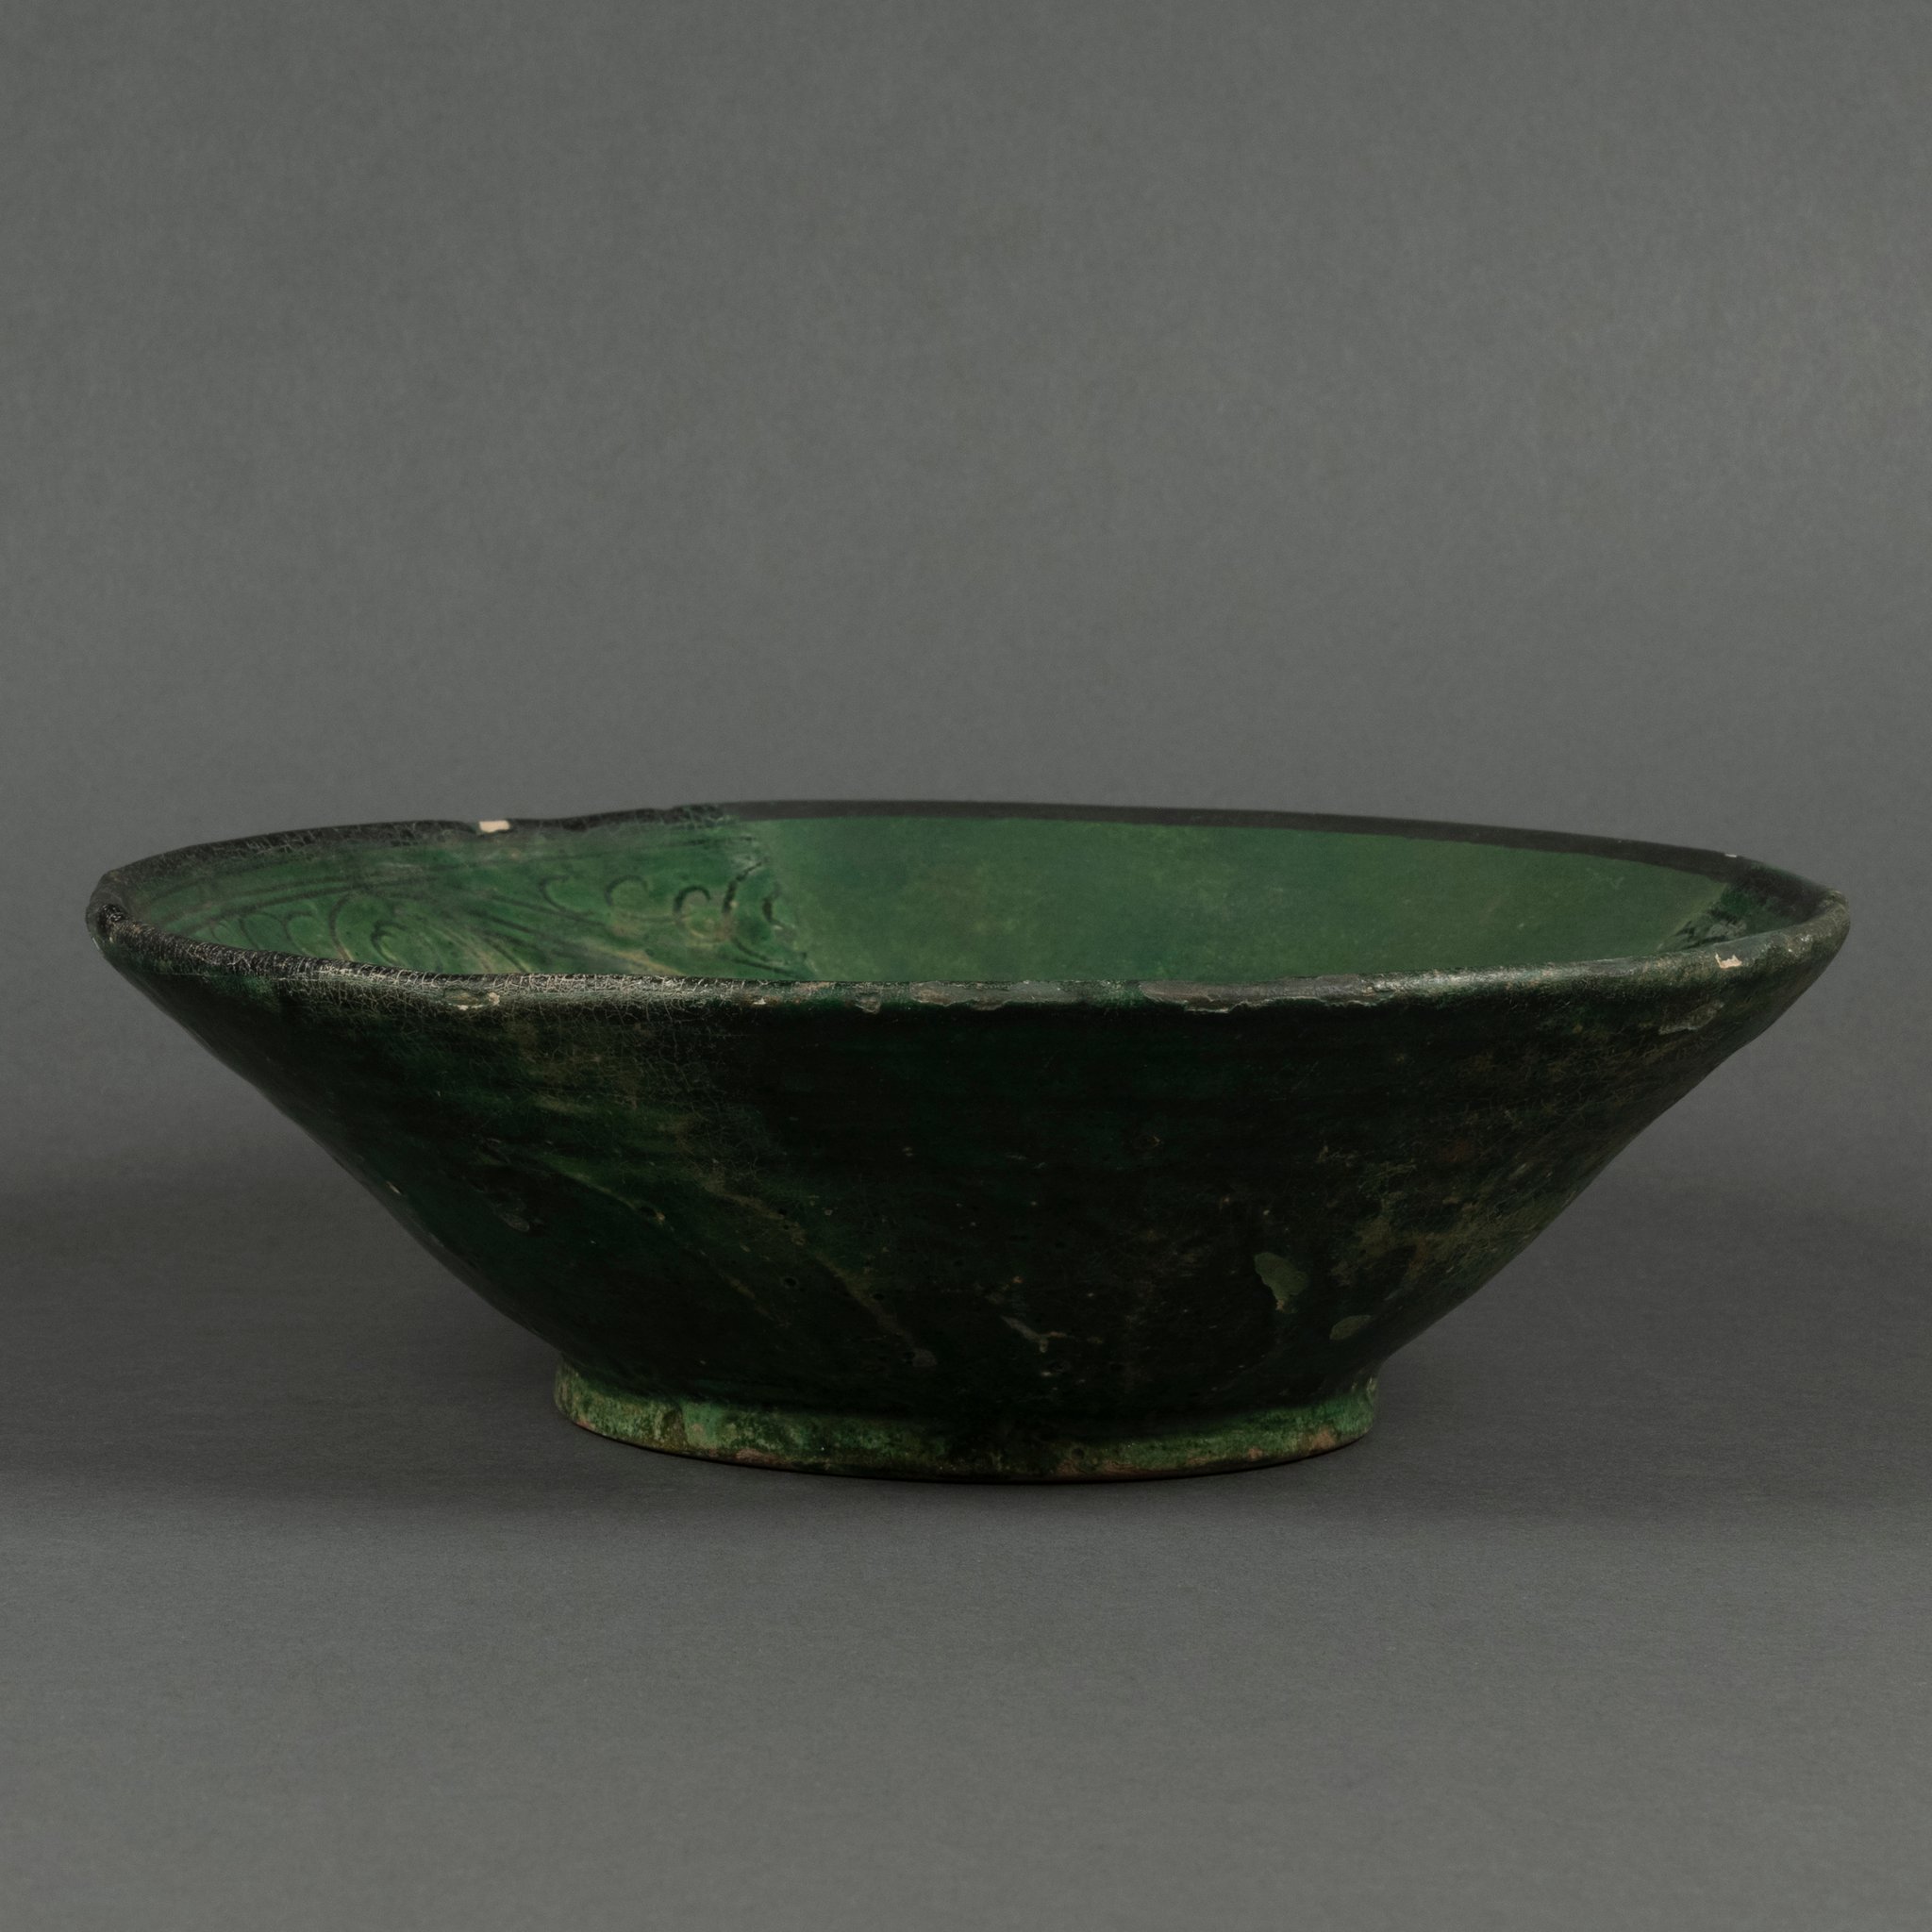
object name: bowl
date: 801-1000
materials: earthenware, glaze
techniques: incising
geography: iran